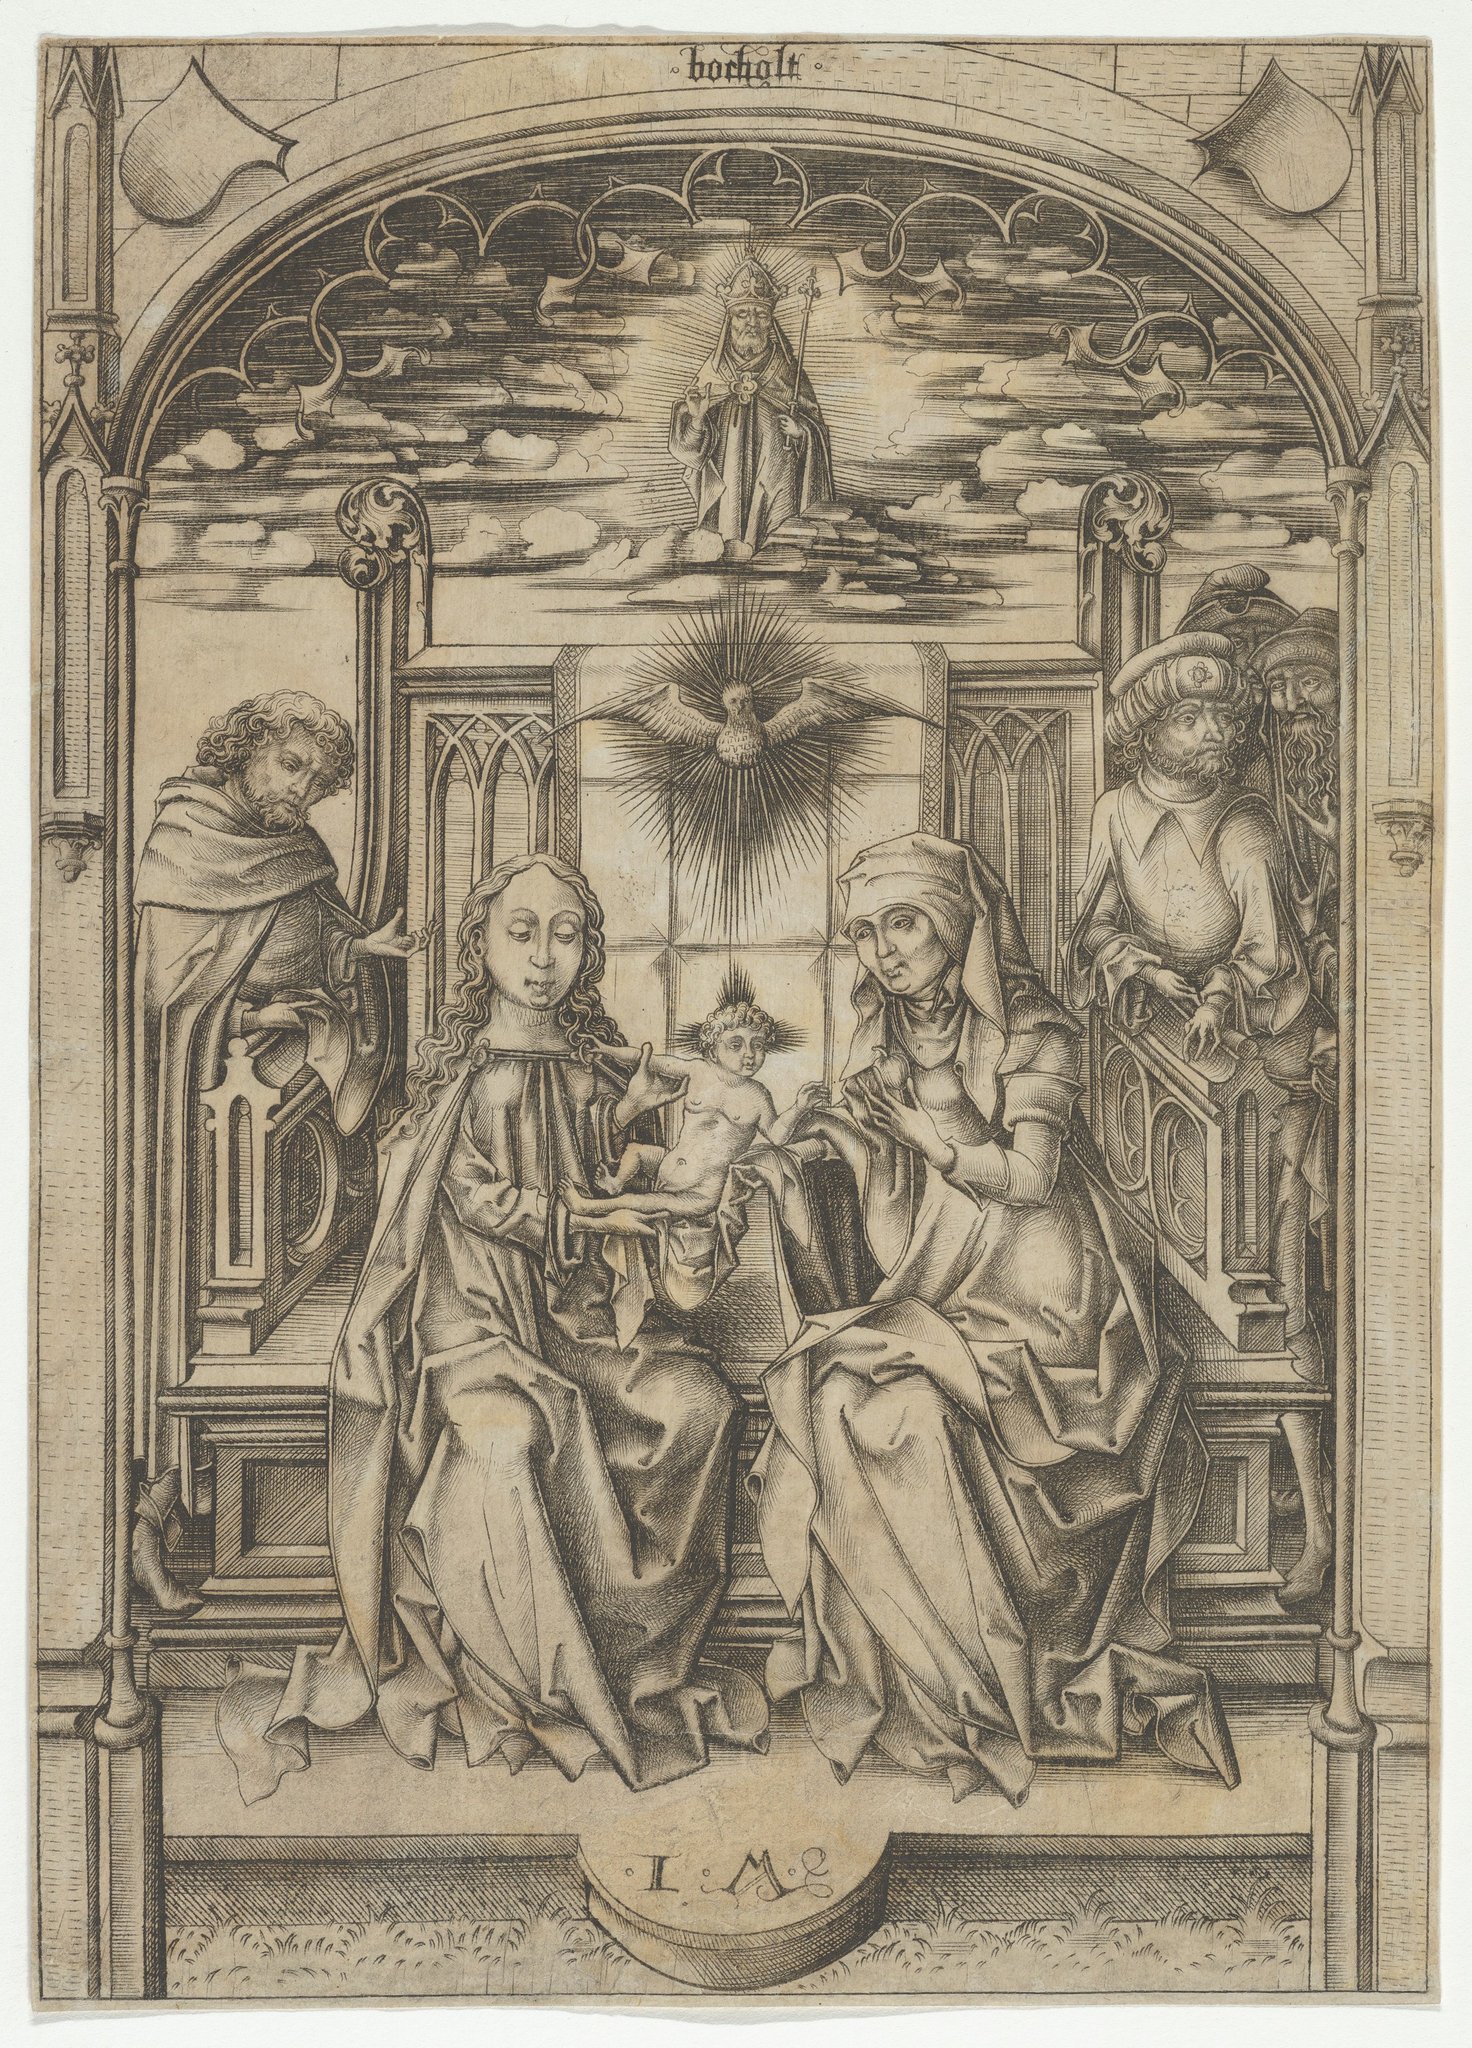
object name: print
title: The Holy Family with St. Anne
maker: israhel van meckenem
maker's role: artist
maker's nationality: german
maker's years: 1435-1503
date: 1435-1503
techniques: engraving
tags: holy family,saint anne,virgin mary,jesus,saints